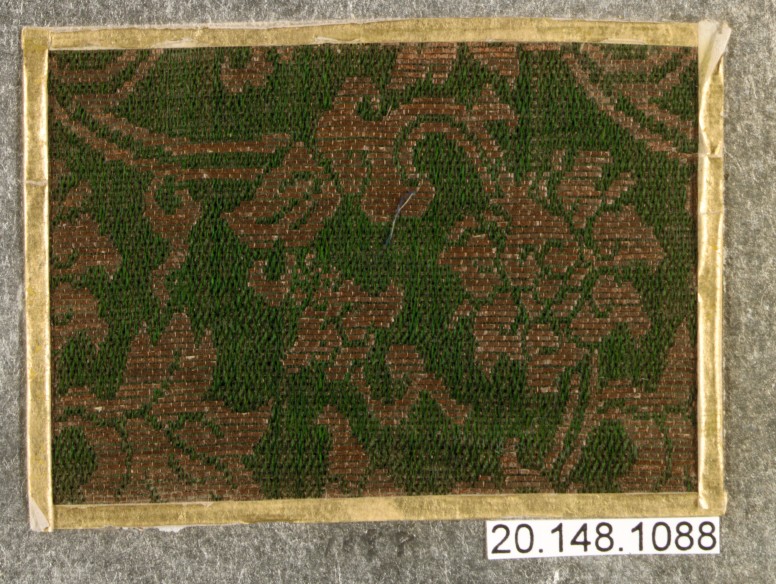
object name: piece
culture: japanese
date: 1701-1800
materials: silk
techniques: compound weave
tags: flowers